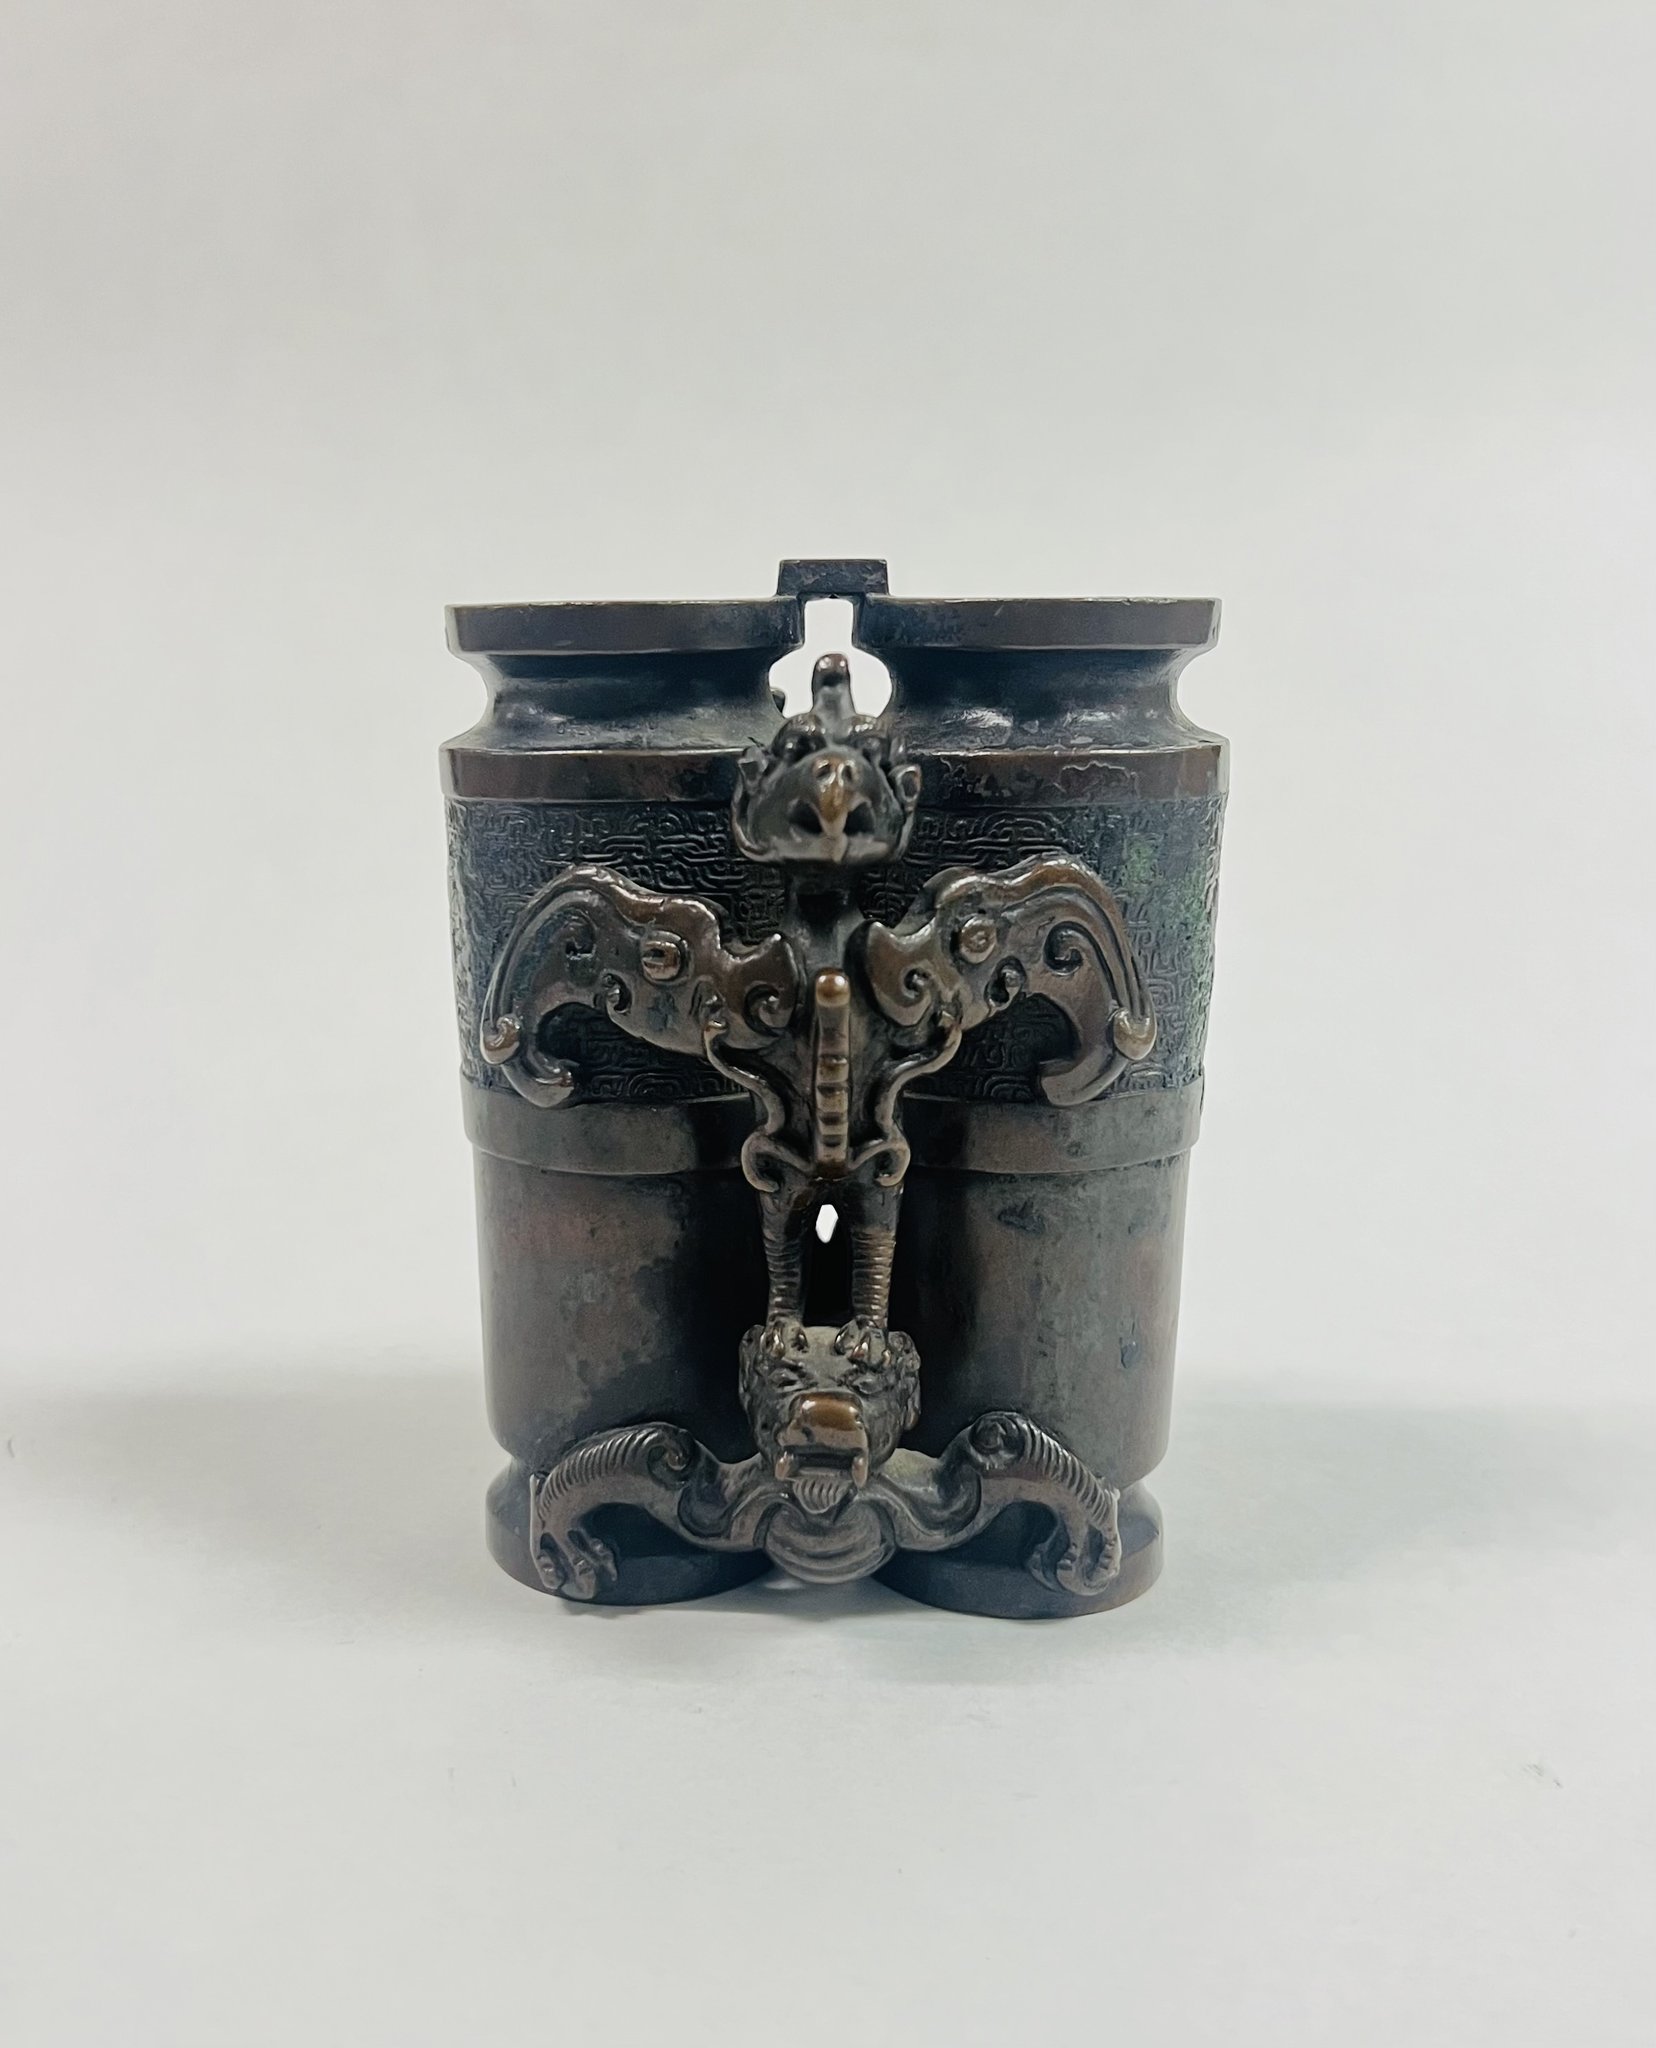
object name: double vase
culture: japanese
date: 1767-1900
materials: bronze